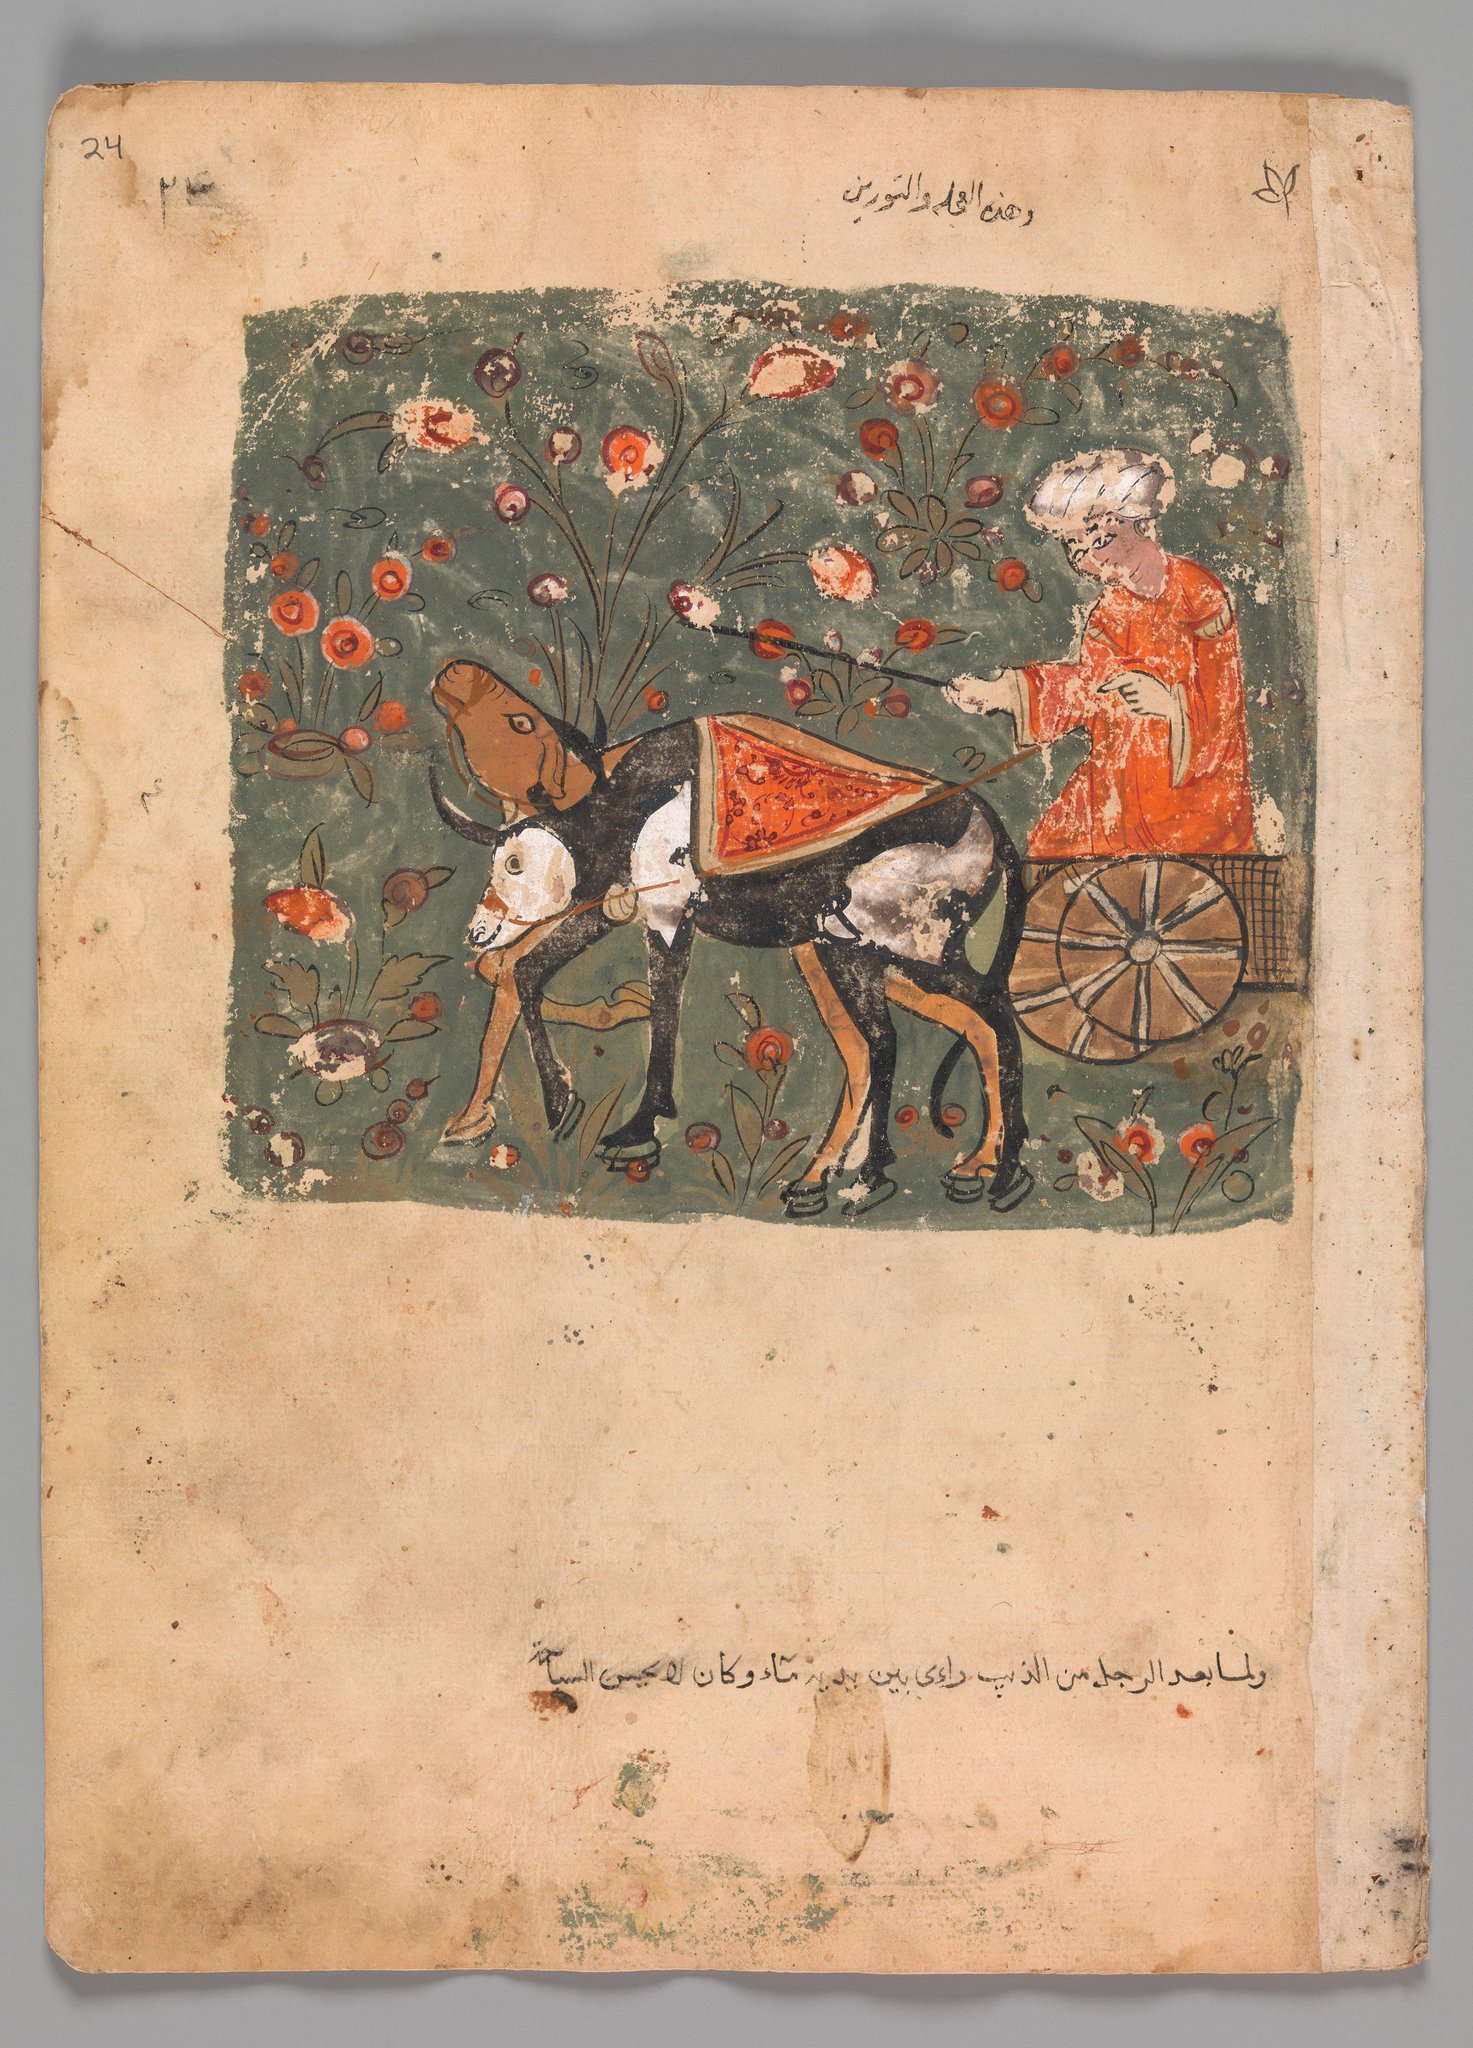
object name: folio from an illustrated manuscript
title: "The Father's Advice Followed by a Son who Sets out to Join a Caravan with the Two Oxen", Folio from a Kalila wa Dimna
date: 1526-1550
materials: ink, paper, watercolor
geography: india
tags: animals,men